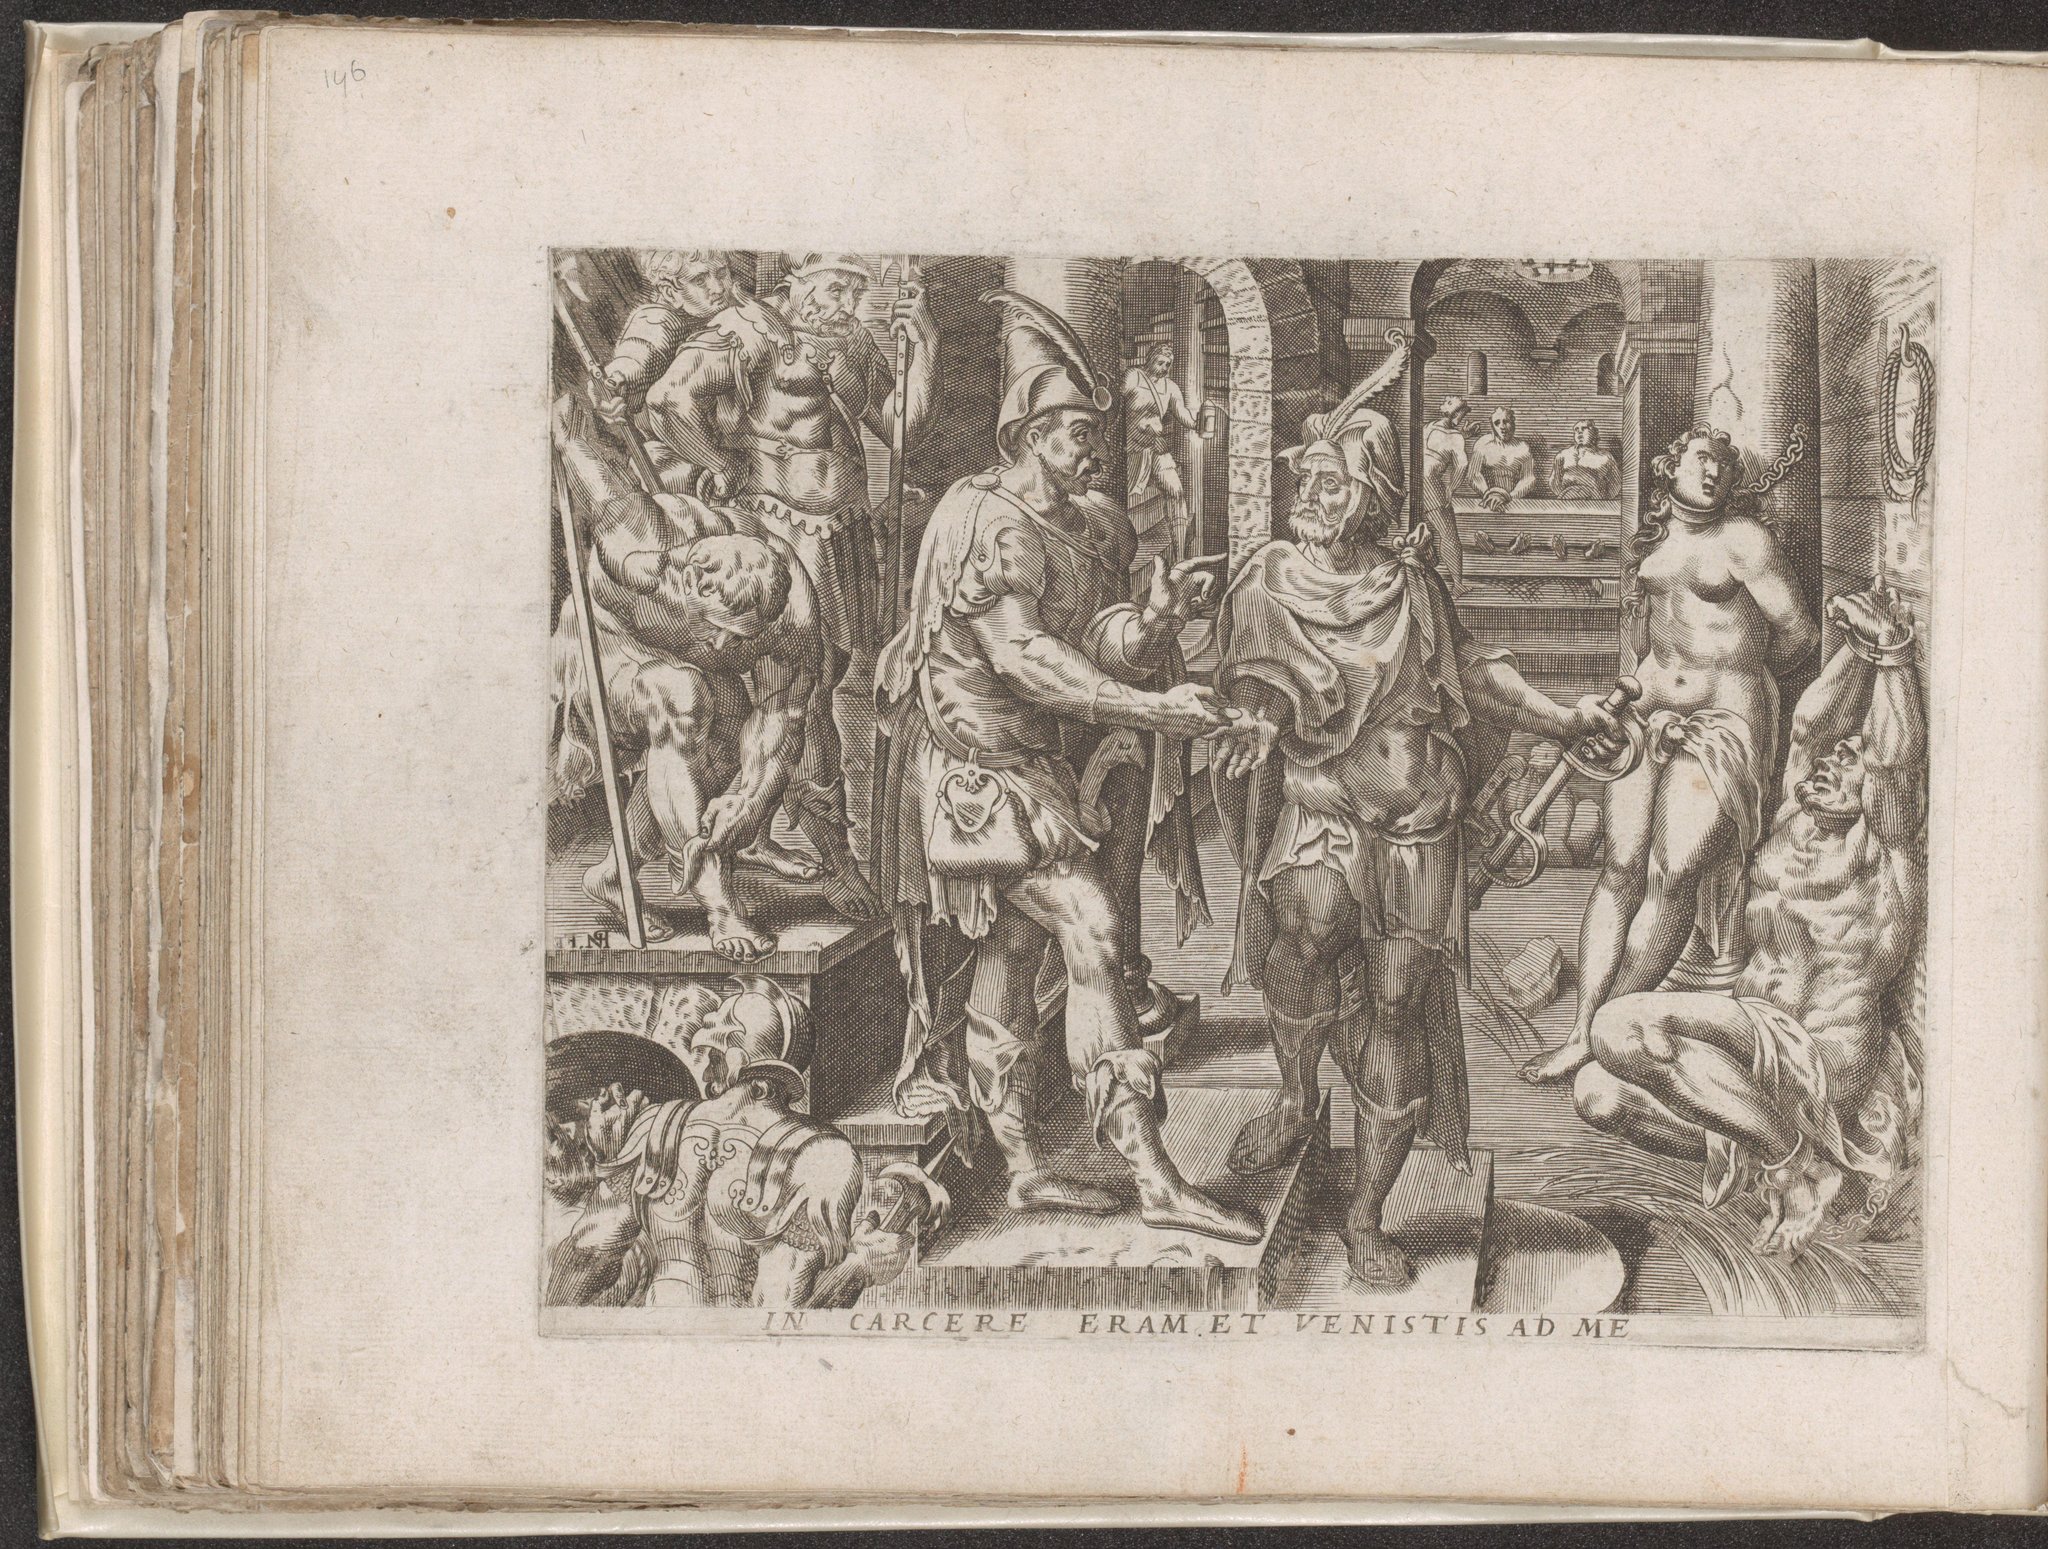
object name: print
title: Bezoeken van de gevangenen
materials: paper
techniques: engraving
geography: antwerp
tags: visiting or liberating the imprisoned, 'incarceratus solatur' ~ one of the (seven) acts of mercy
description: Twee mannen bezoeken de gevangenen. Links op de trap een voorover gebogen bezoeker en een soldaat. Rechts twee aan de muur geketende gevangenen en op de achtergrond andere gevangenen. Onder de voorstelling een verklarende tekst in het Latijn. Deze prent maakt deel uit van een album.